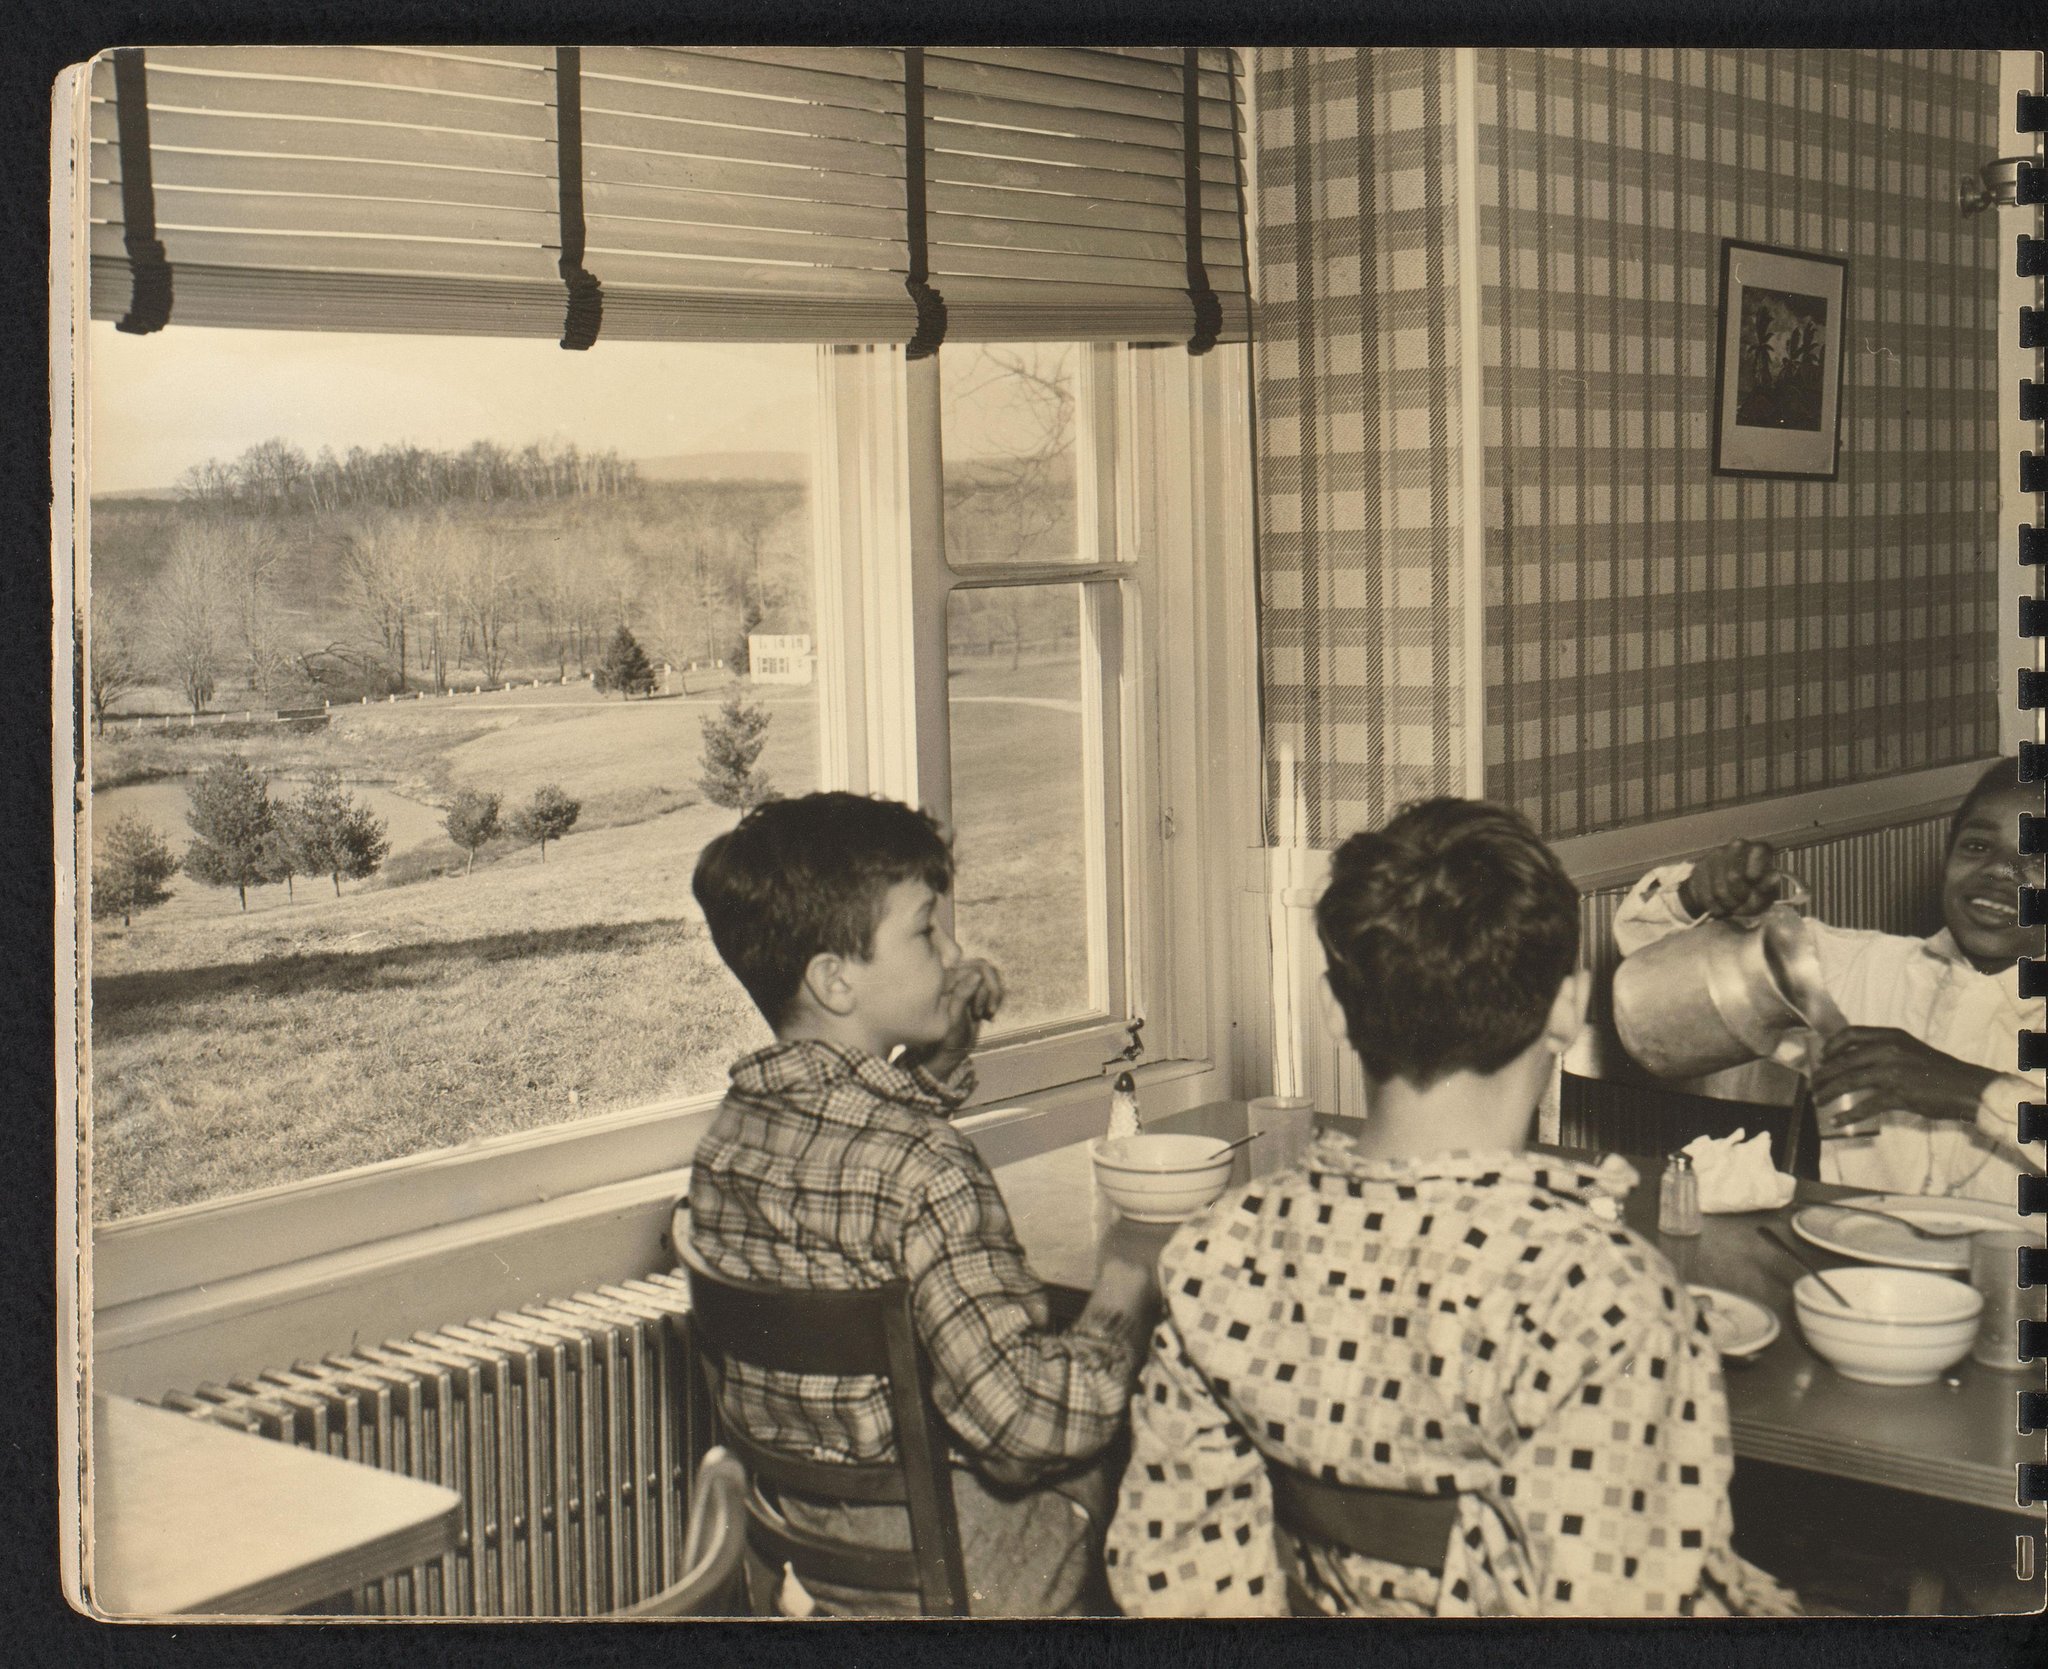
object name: photograph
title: Eetkamer in het hoofdgebouw, met drie jongens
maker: Anonymous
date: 1950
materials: paper, photographic support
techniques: gelatin silver print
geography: new york city